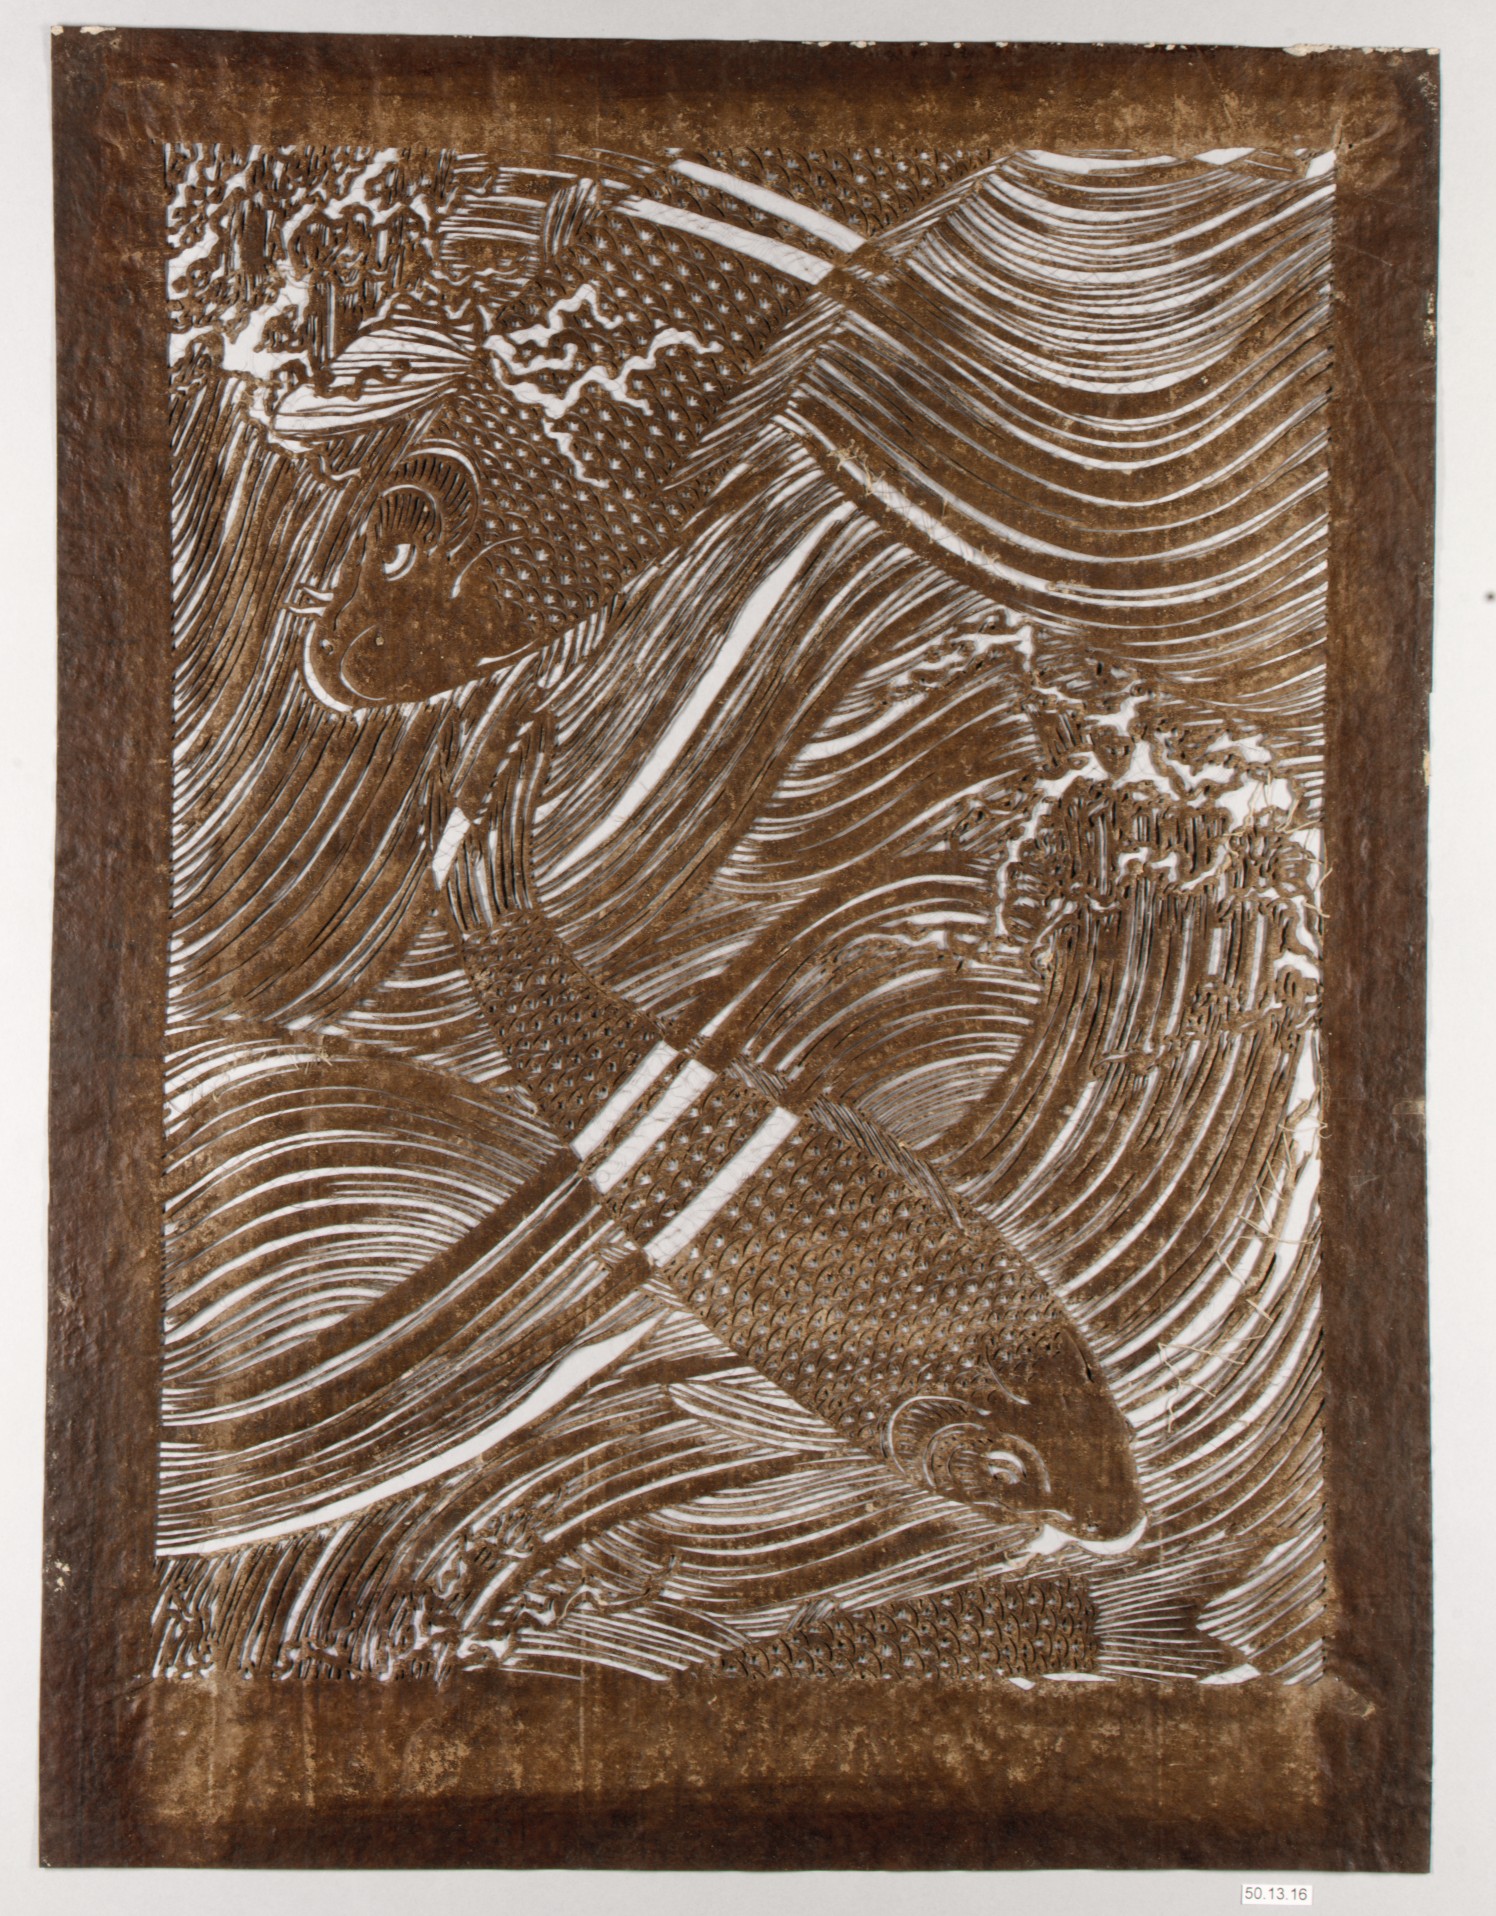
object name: stencil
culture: japanese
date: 1801-1900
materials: paper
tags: fish